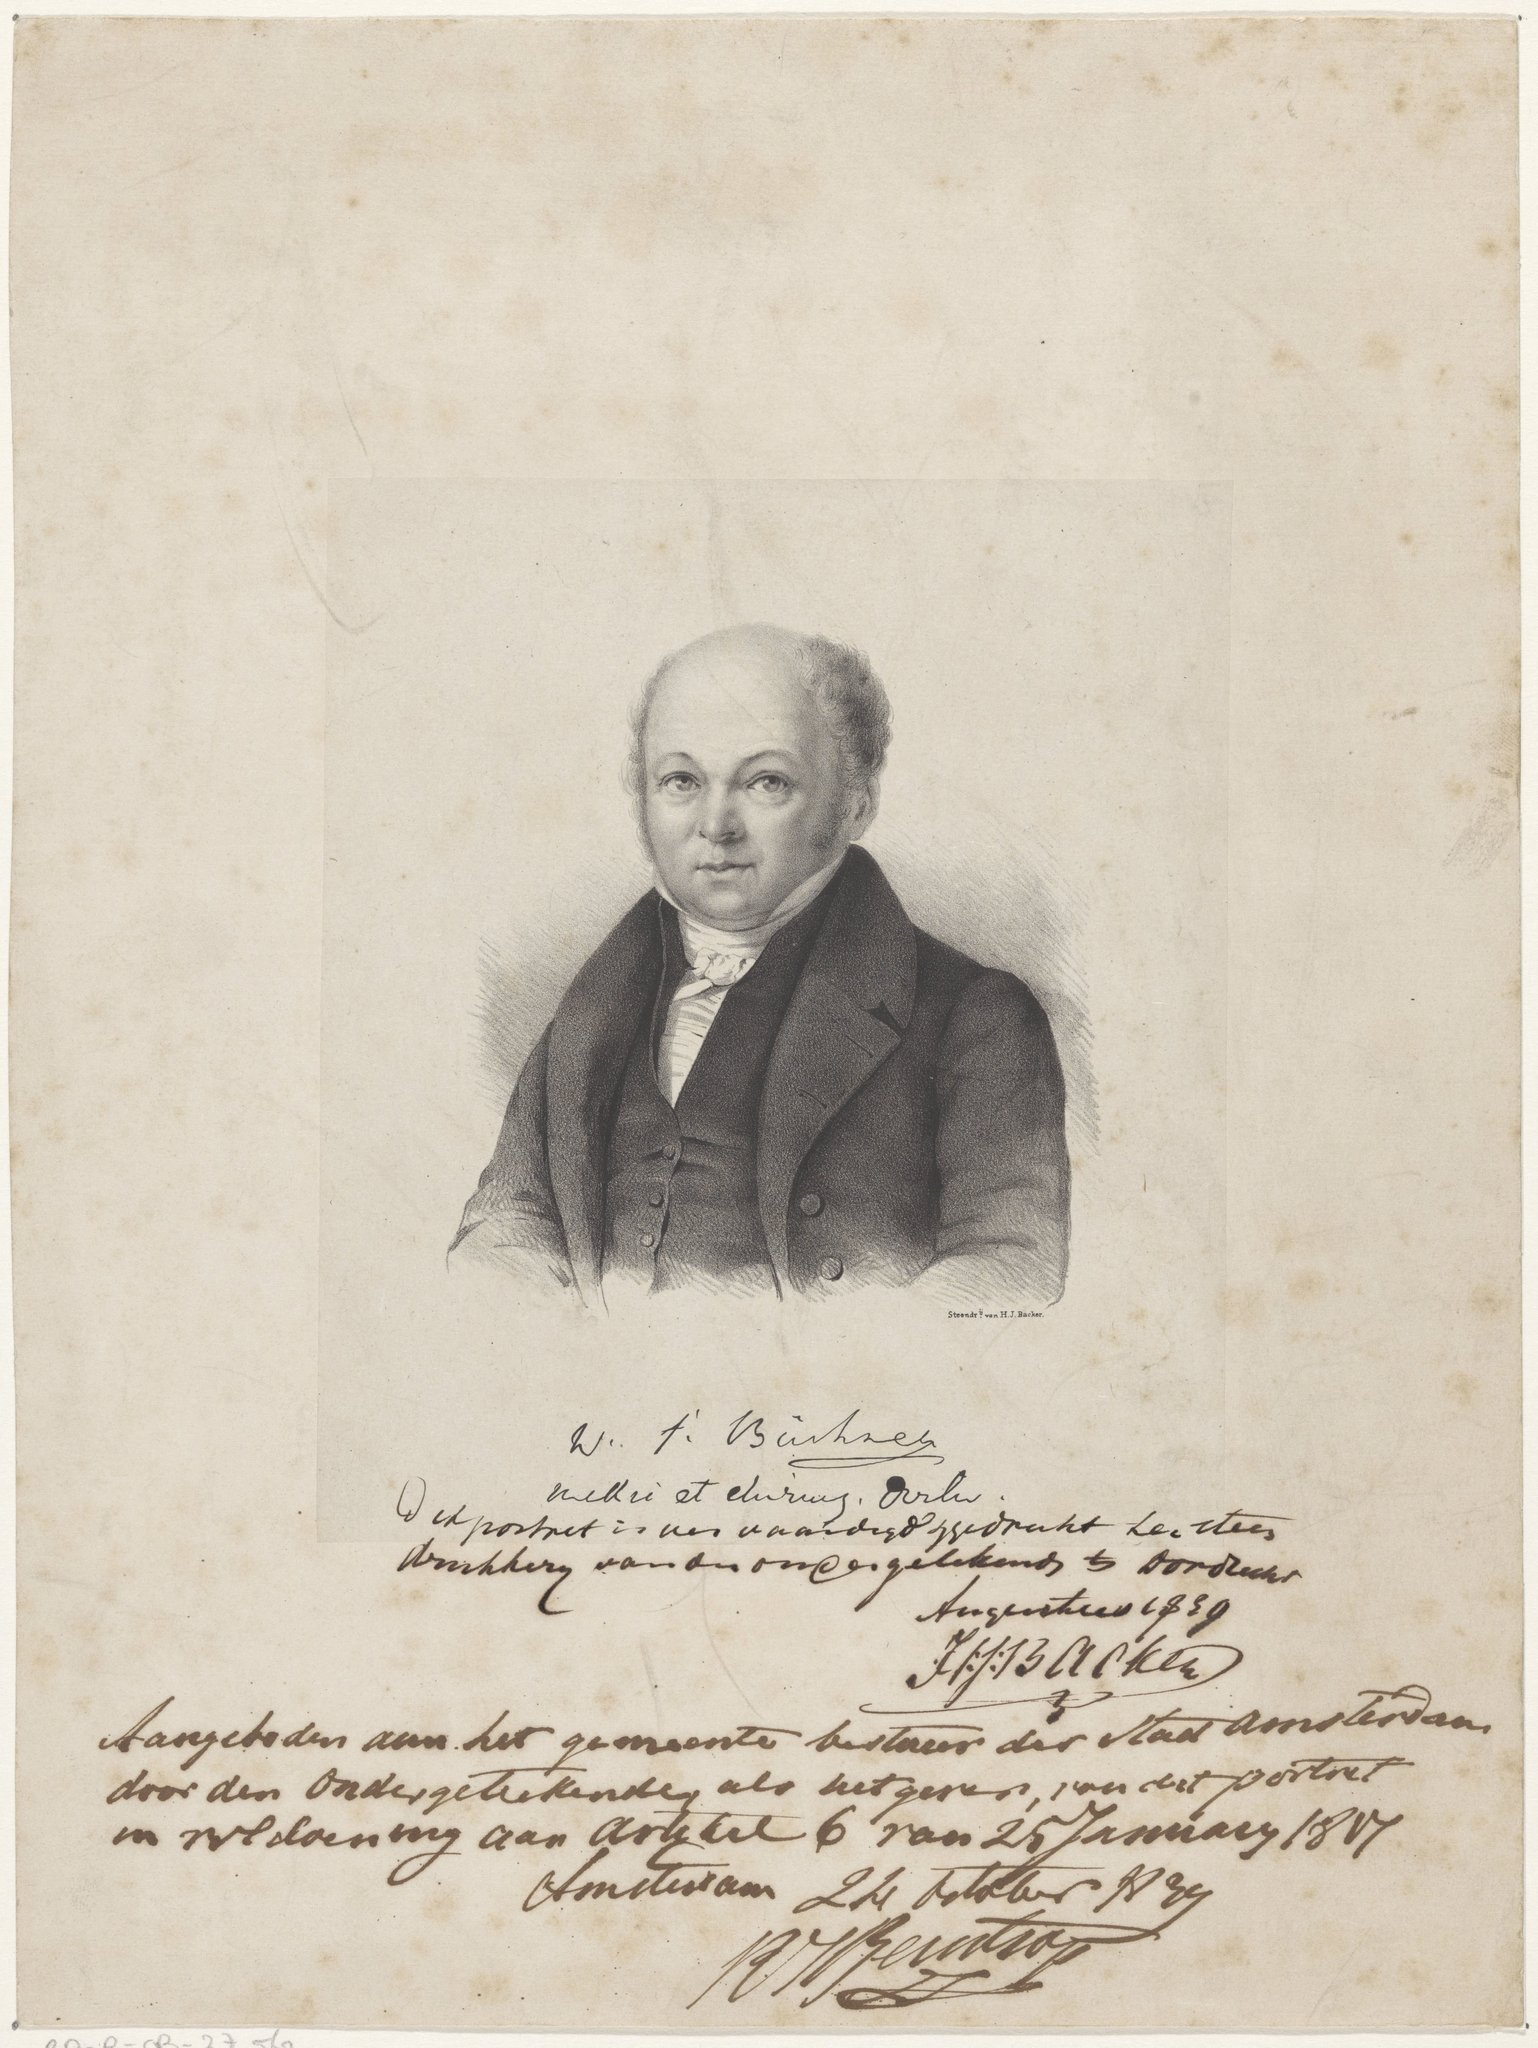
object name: print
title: Portret van Willem Frederik Büchner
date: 1839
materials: paper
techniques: lithograph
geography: amsterdam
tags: historical persons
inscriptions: : ‘W. F. Büchner / Medici et chirurg (...) / Als portret is het vervaardigd en gedrukt (...) / drukkerij van den ondergetekende te Dordrecht / Augustus 1839 / H. J. Backer / Aangeboden aan het gemeentebestuur der stad Amsterdam / door den ondergetekende als uitgever van het portret / in voldoening aan artikel 6 van 25 januari 1817 / Amsterdam 24 oktober 1839 / R. J. Berntrop’, collector's mark: Lugt 2228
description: Onder het portret de naam en het beroep van de geportretteerde.